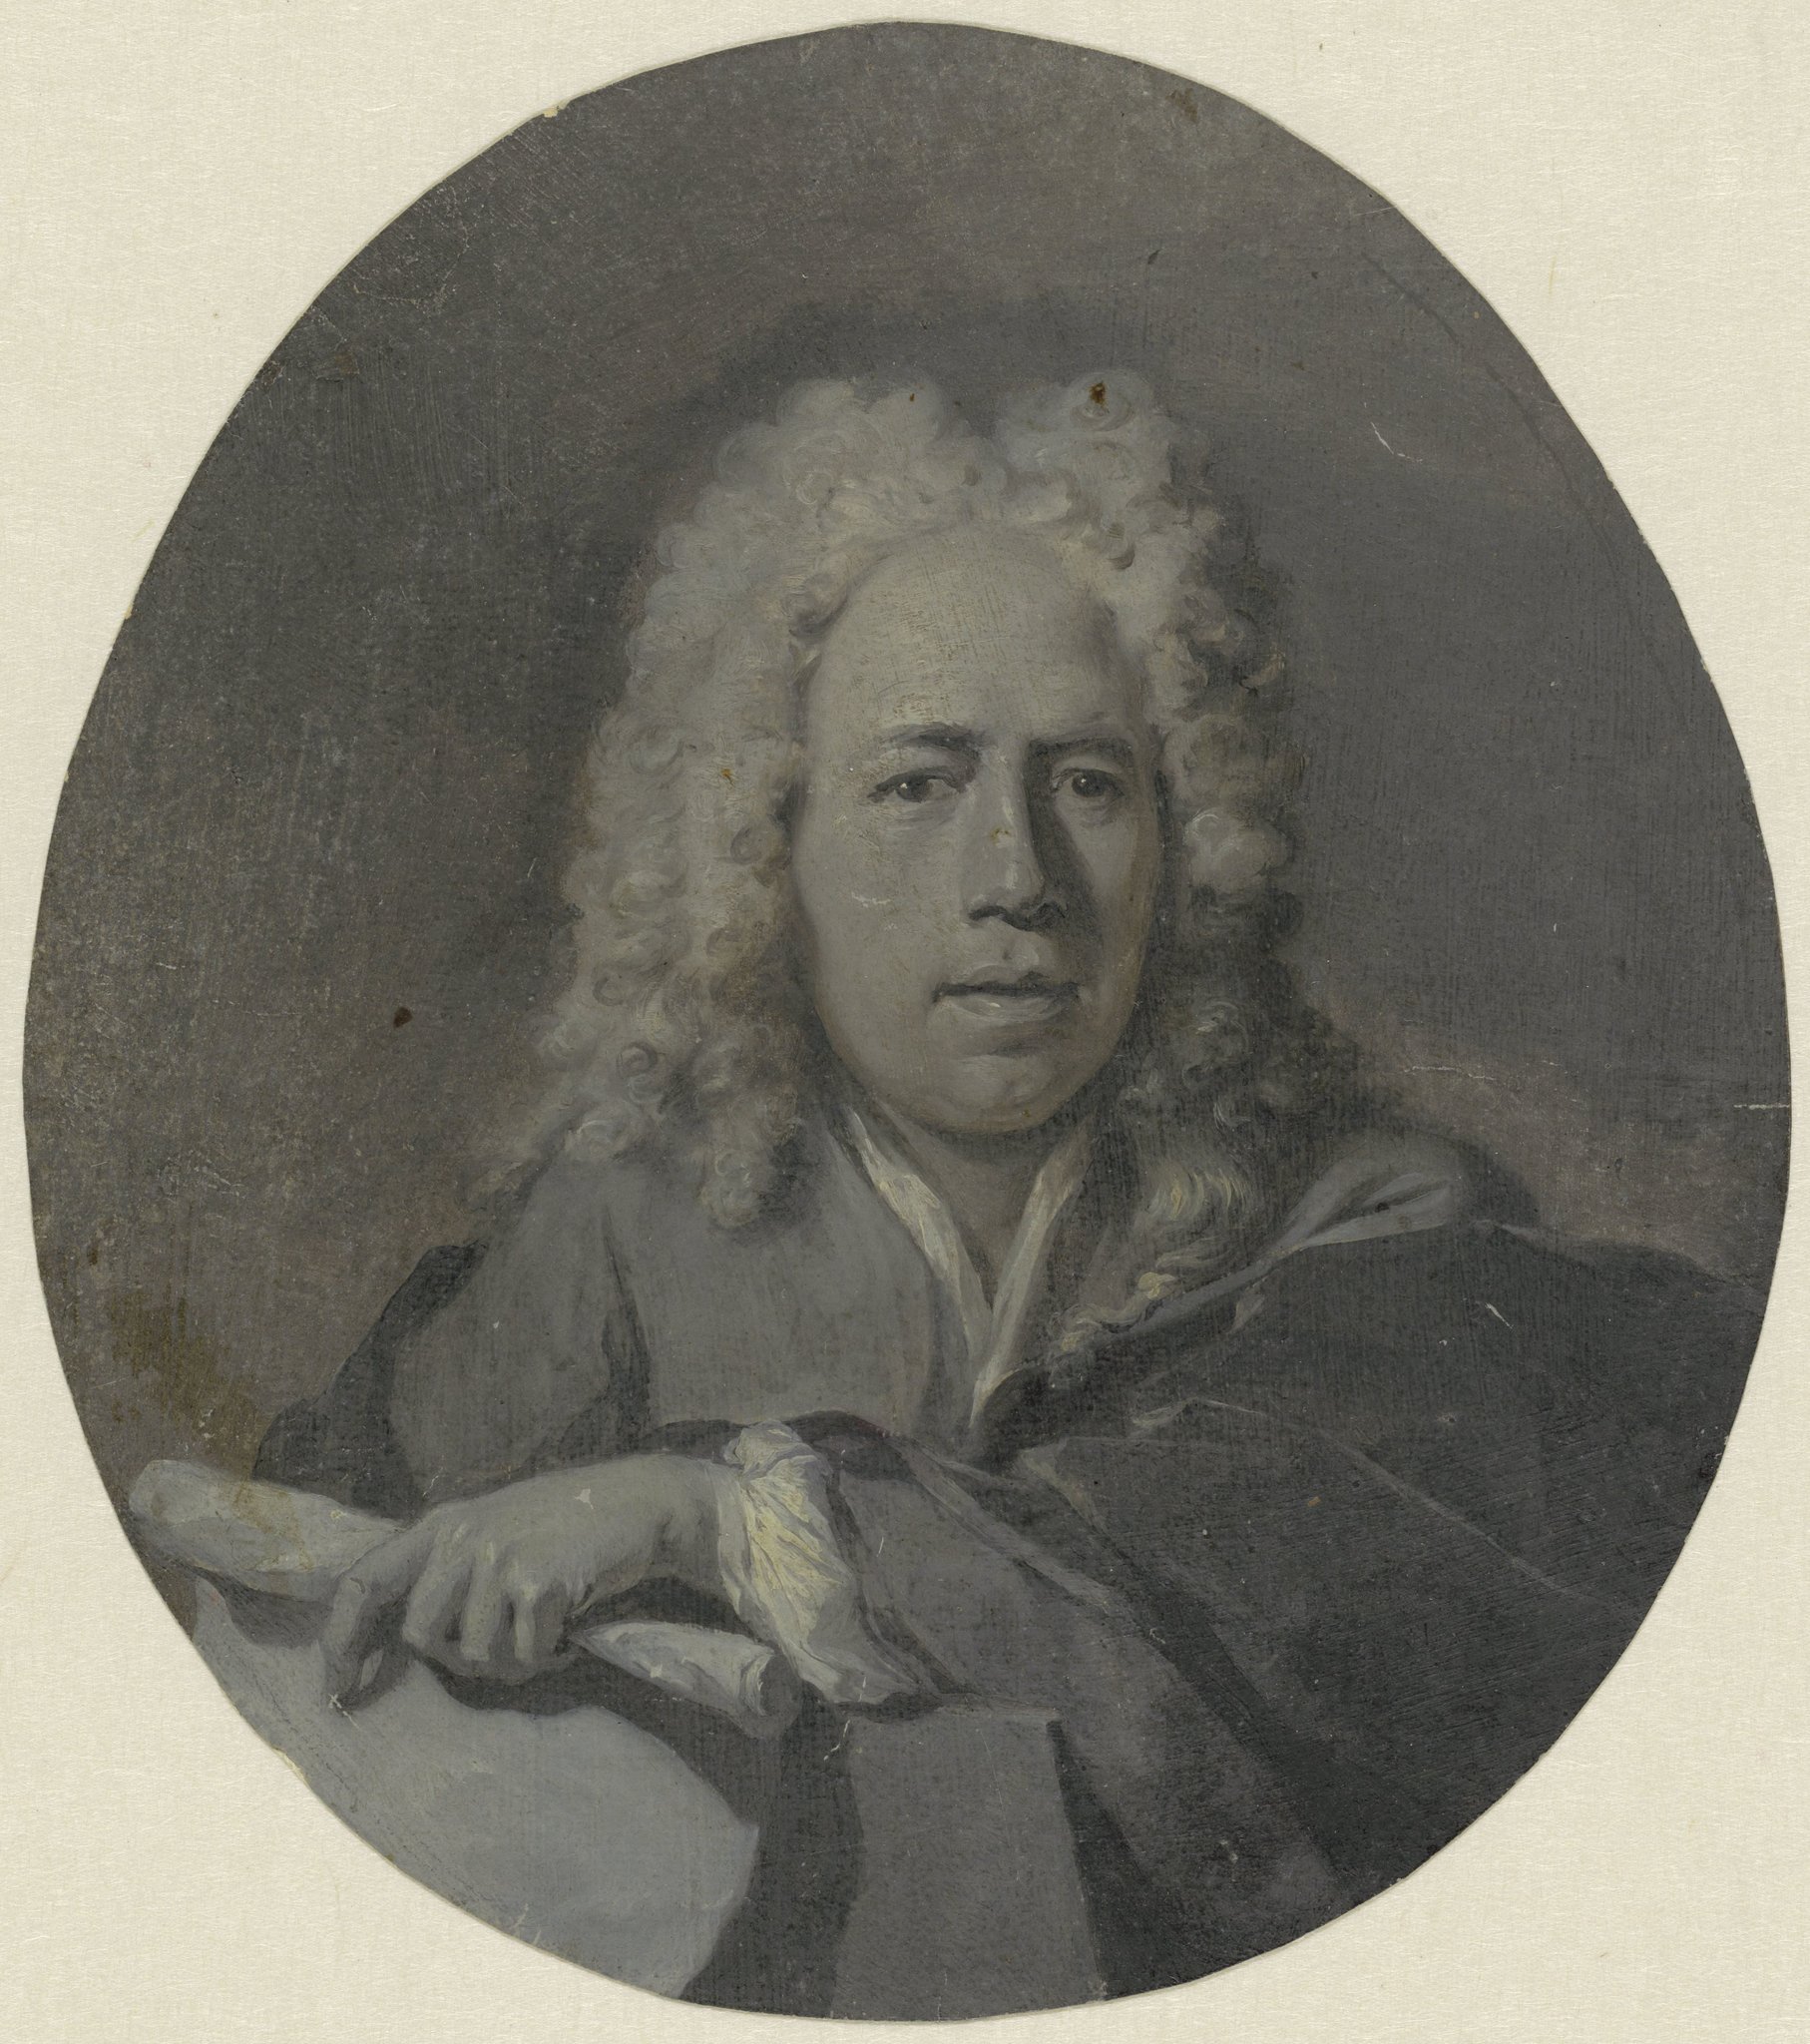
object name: drawing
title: Portret van de schilder Carel Borchaert Voet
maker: nicolaas verkolje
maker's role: draughtsman, painter, print maker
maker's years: 1673-1746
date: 1720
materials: oil, paper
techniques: brush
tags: dordrecht, carel borchaert voet, historical persons, portrait, self-portrait of painter, portrait, self-portrait of artist